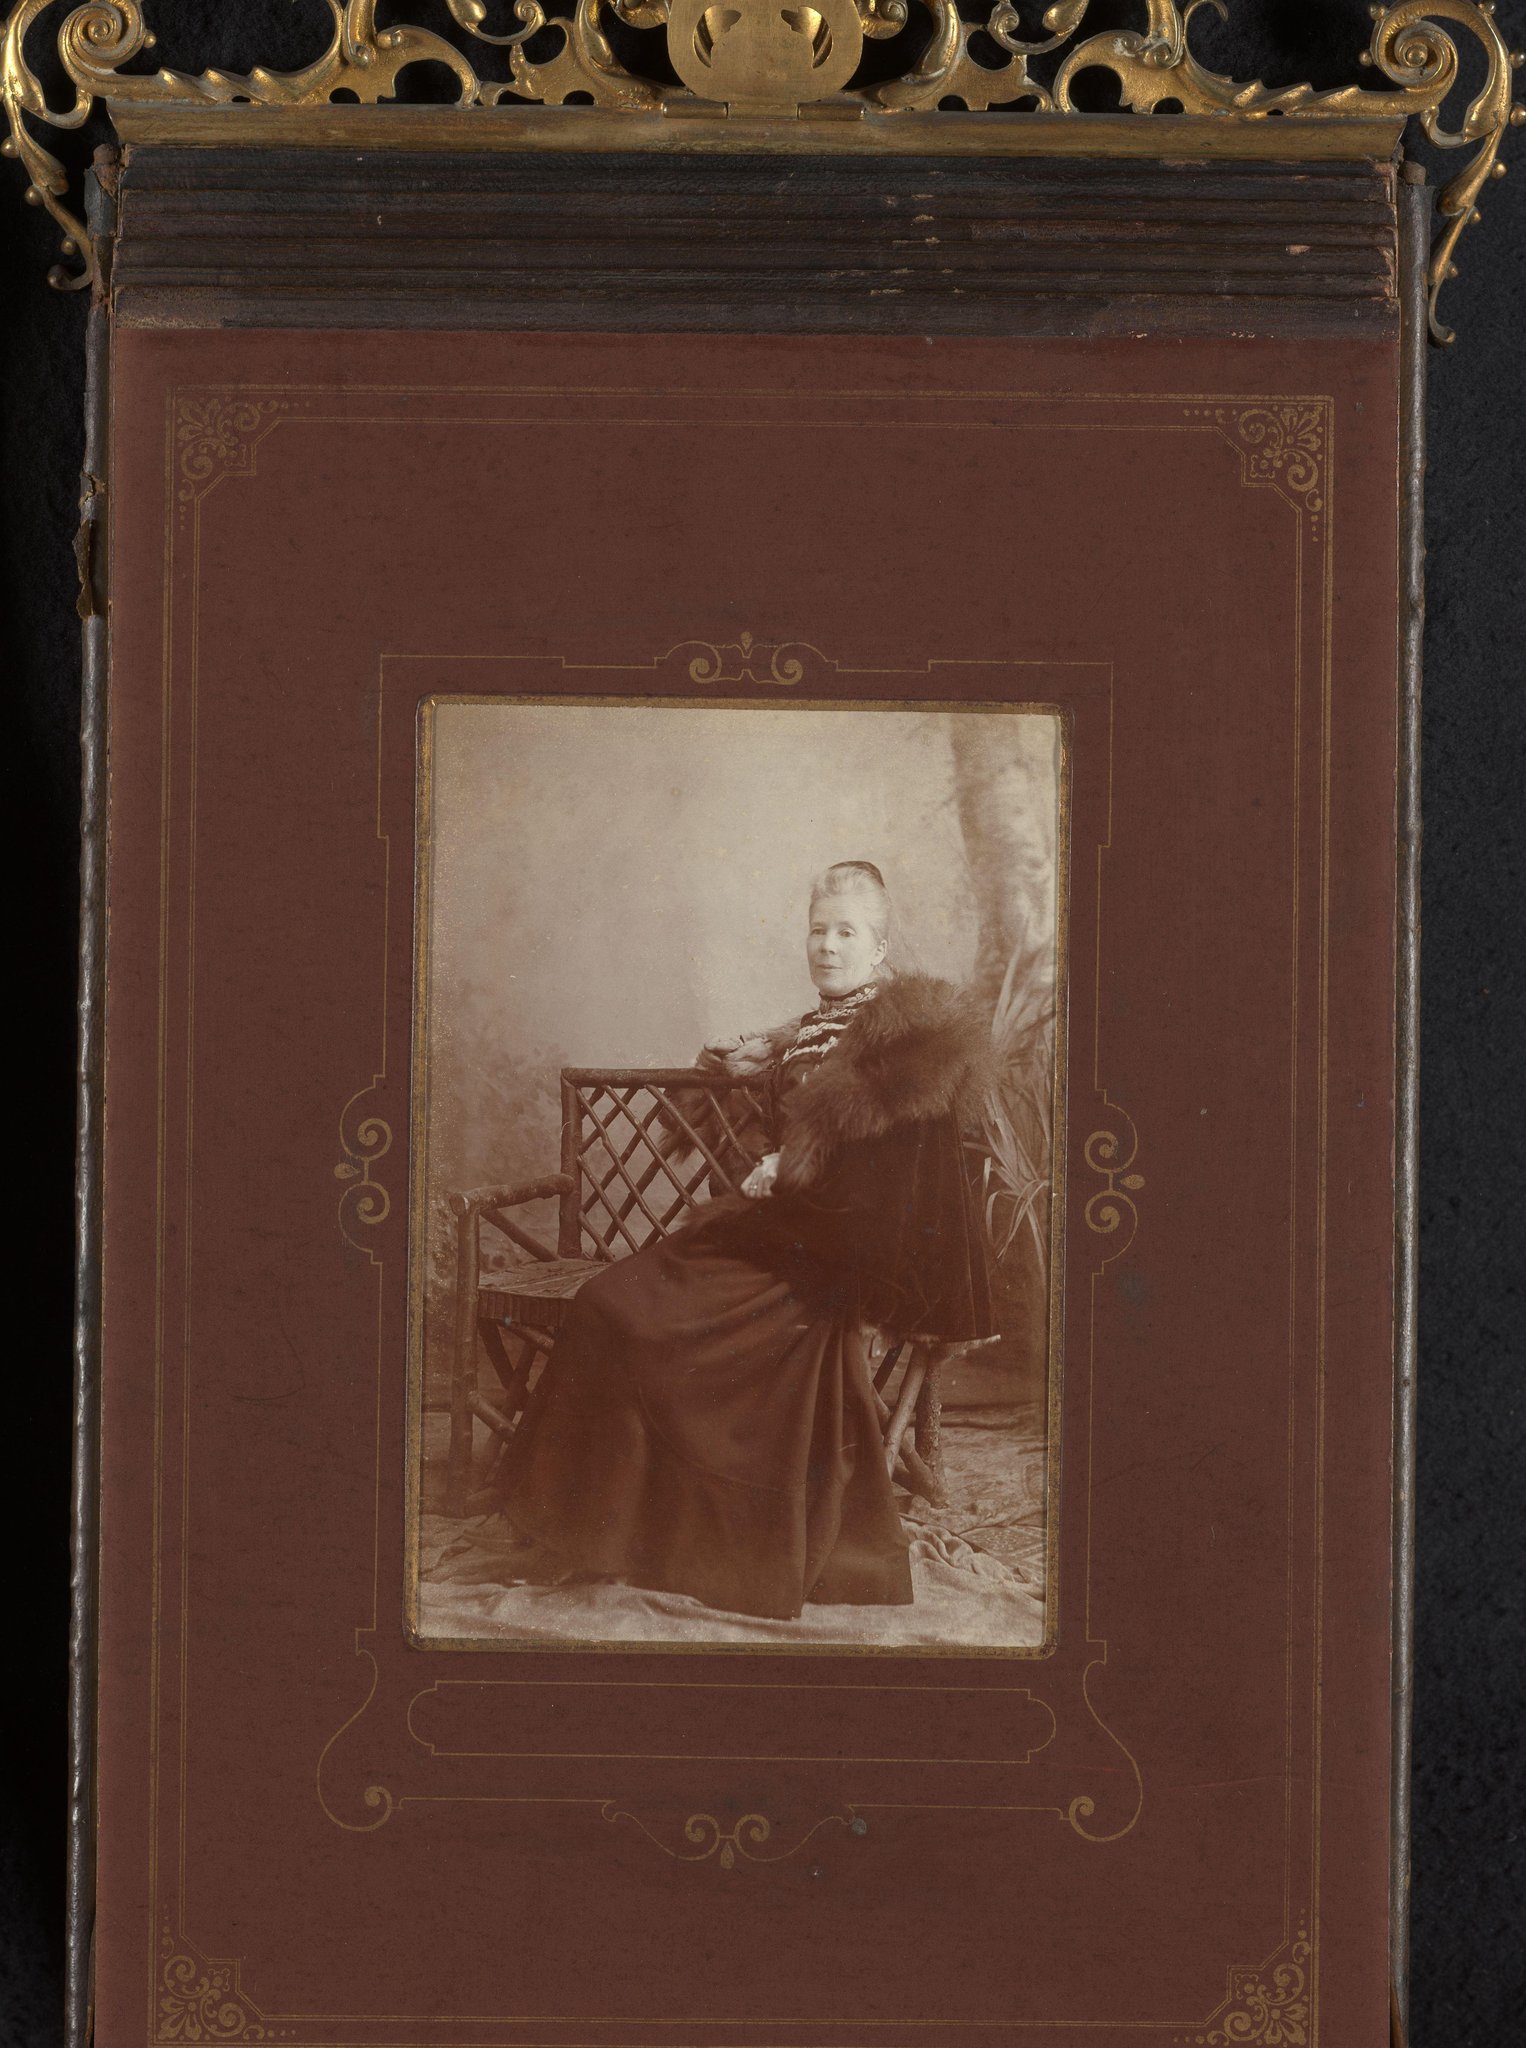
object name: photograph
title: Portret van een zittende vrouw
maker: edward bradford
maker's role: fotograaf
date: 1880-1920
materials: cardboard, photographic support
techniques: gelatin silver print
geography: ireland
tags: sitting figure - aa - female human figure, historical persons - bb - woman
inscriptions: inscription: ‘Instantaneous portraits of children/ a successful specialty/ Artist Photographer (...) Edward Bradford/ Studio/ Railway Road/ Dalkey’